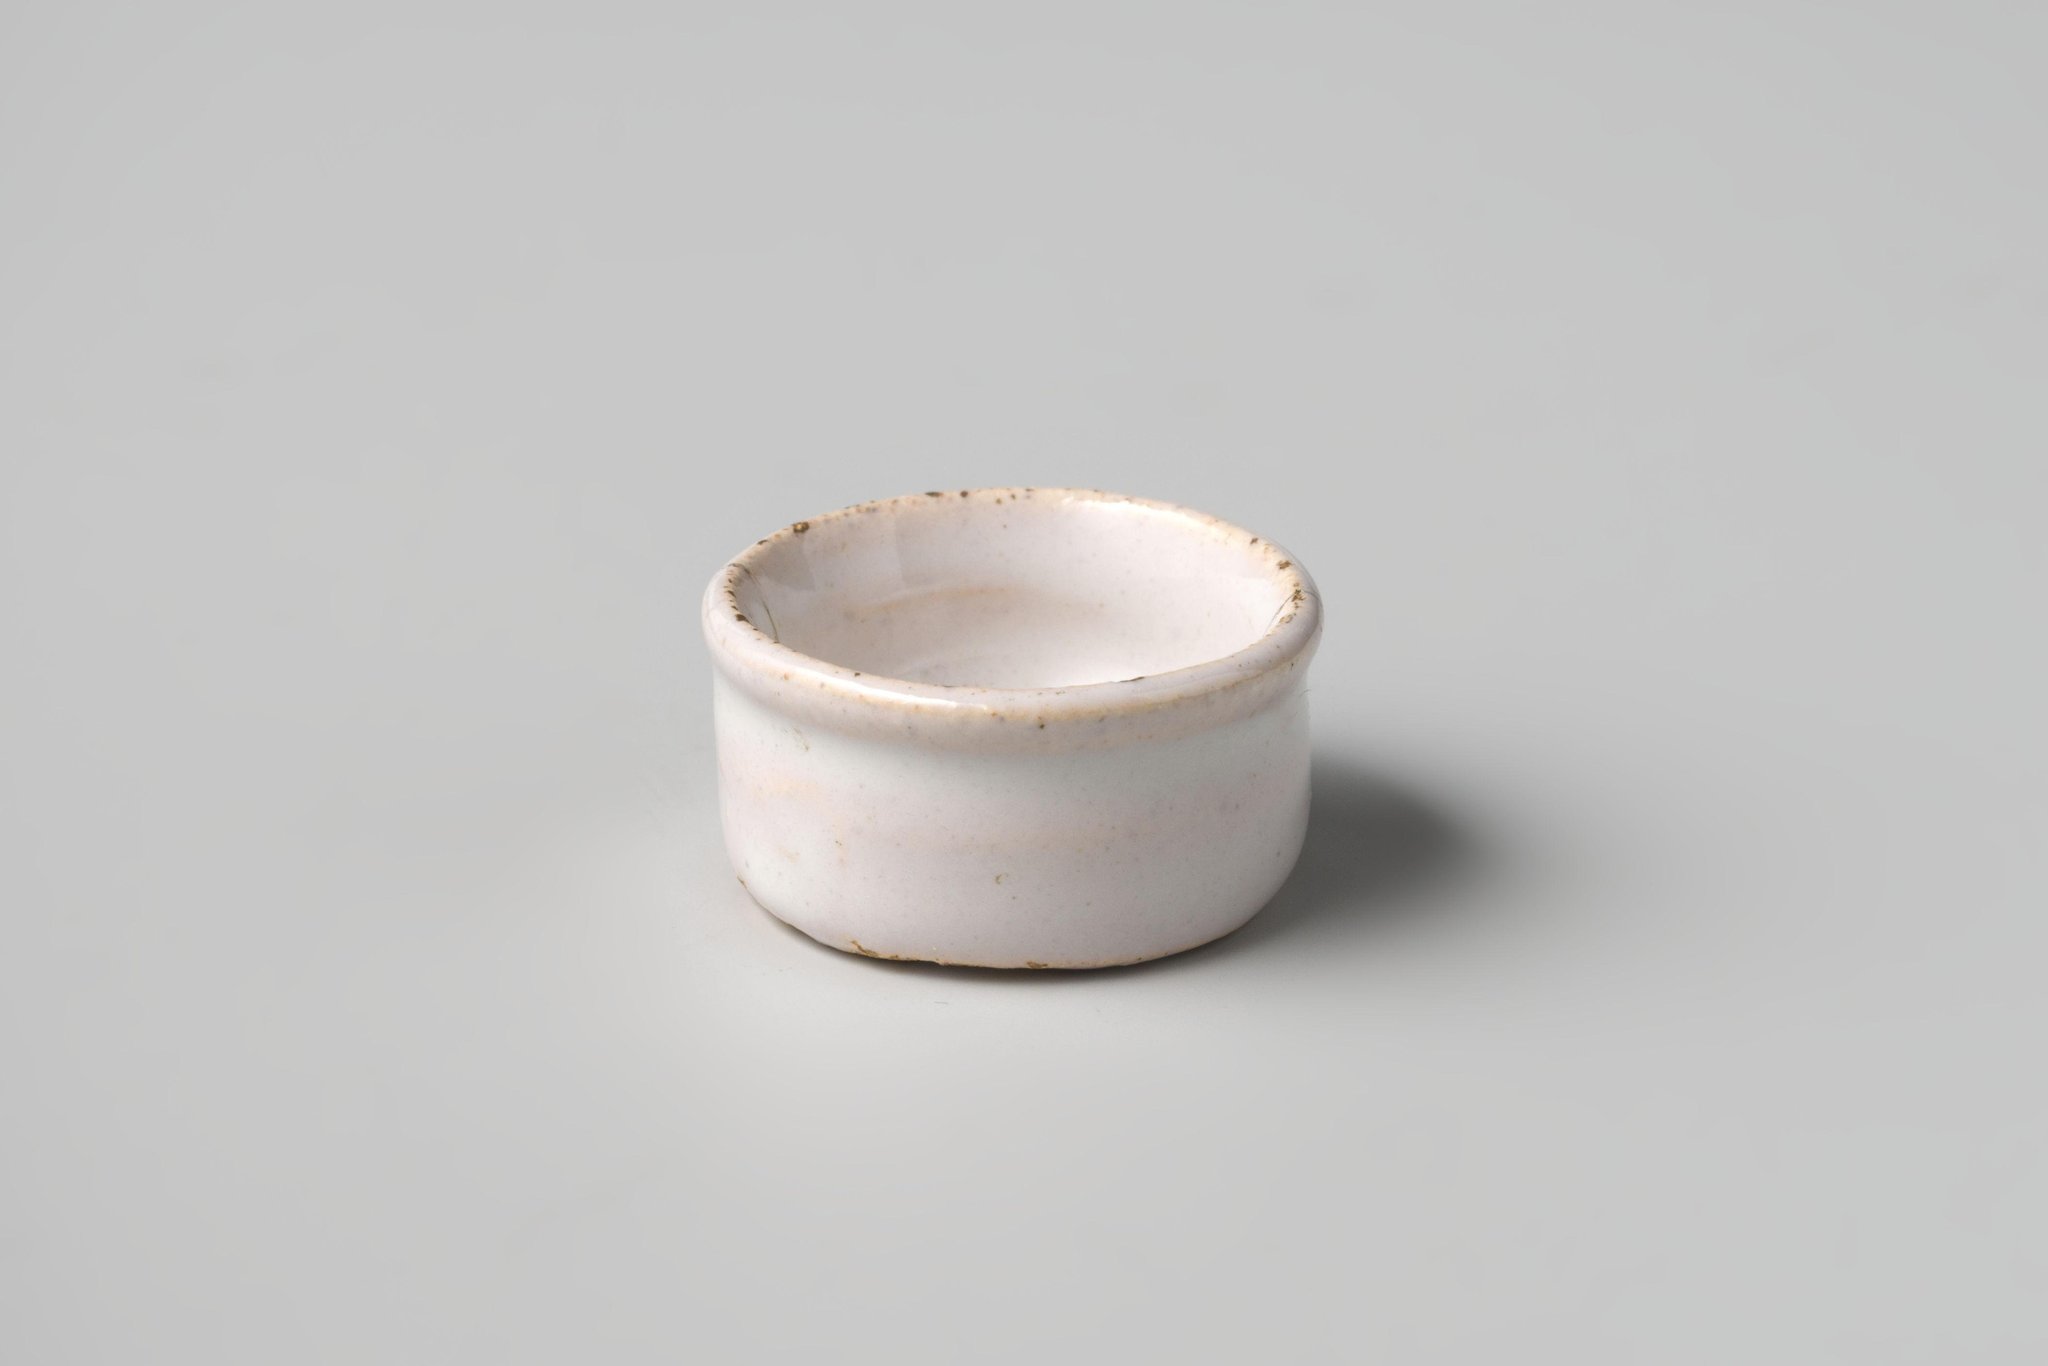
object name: bowl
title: Kom, cilindervormig, met witte glazuur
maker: Anonymous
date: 1700-1799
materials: earthenware, glaze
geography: delft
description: Kom van aardewerk, cilindervormig, met insnoering onder de bovenrand, met lichtgele scherf en witte tinglazuur. Op de bodem is slechts weinig glazuur aangebracht.